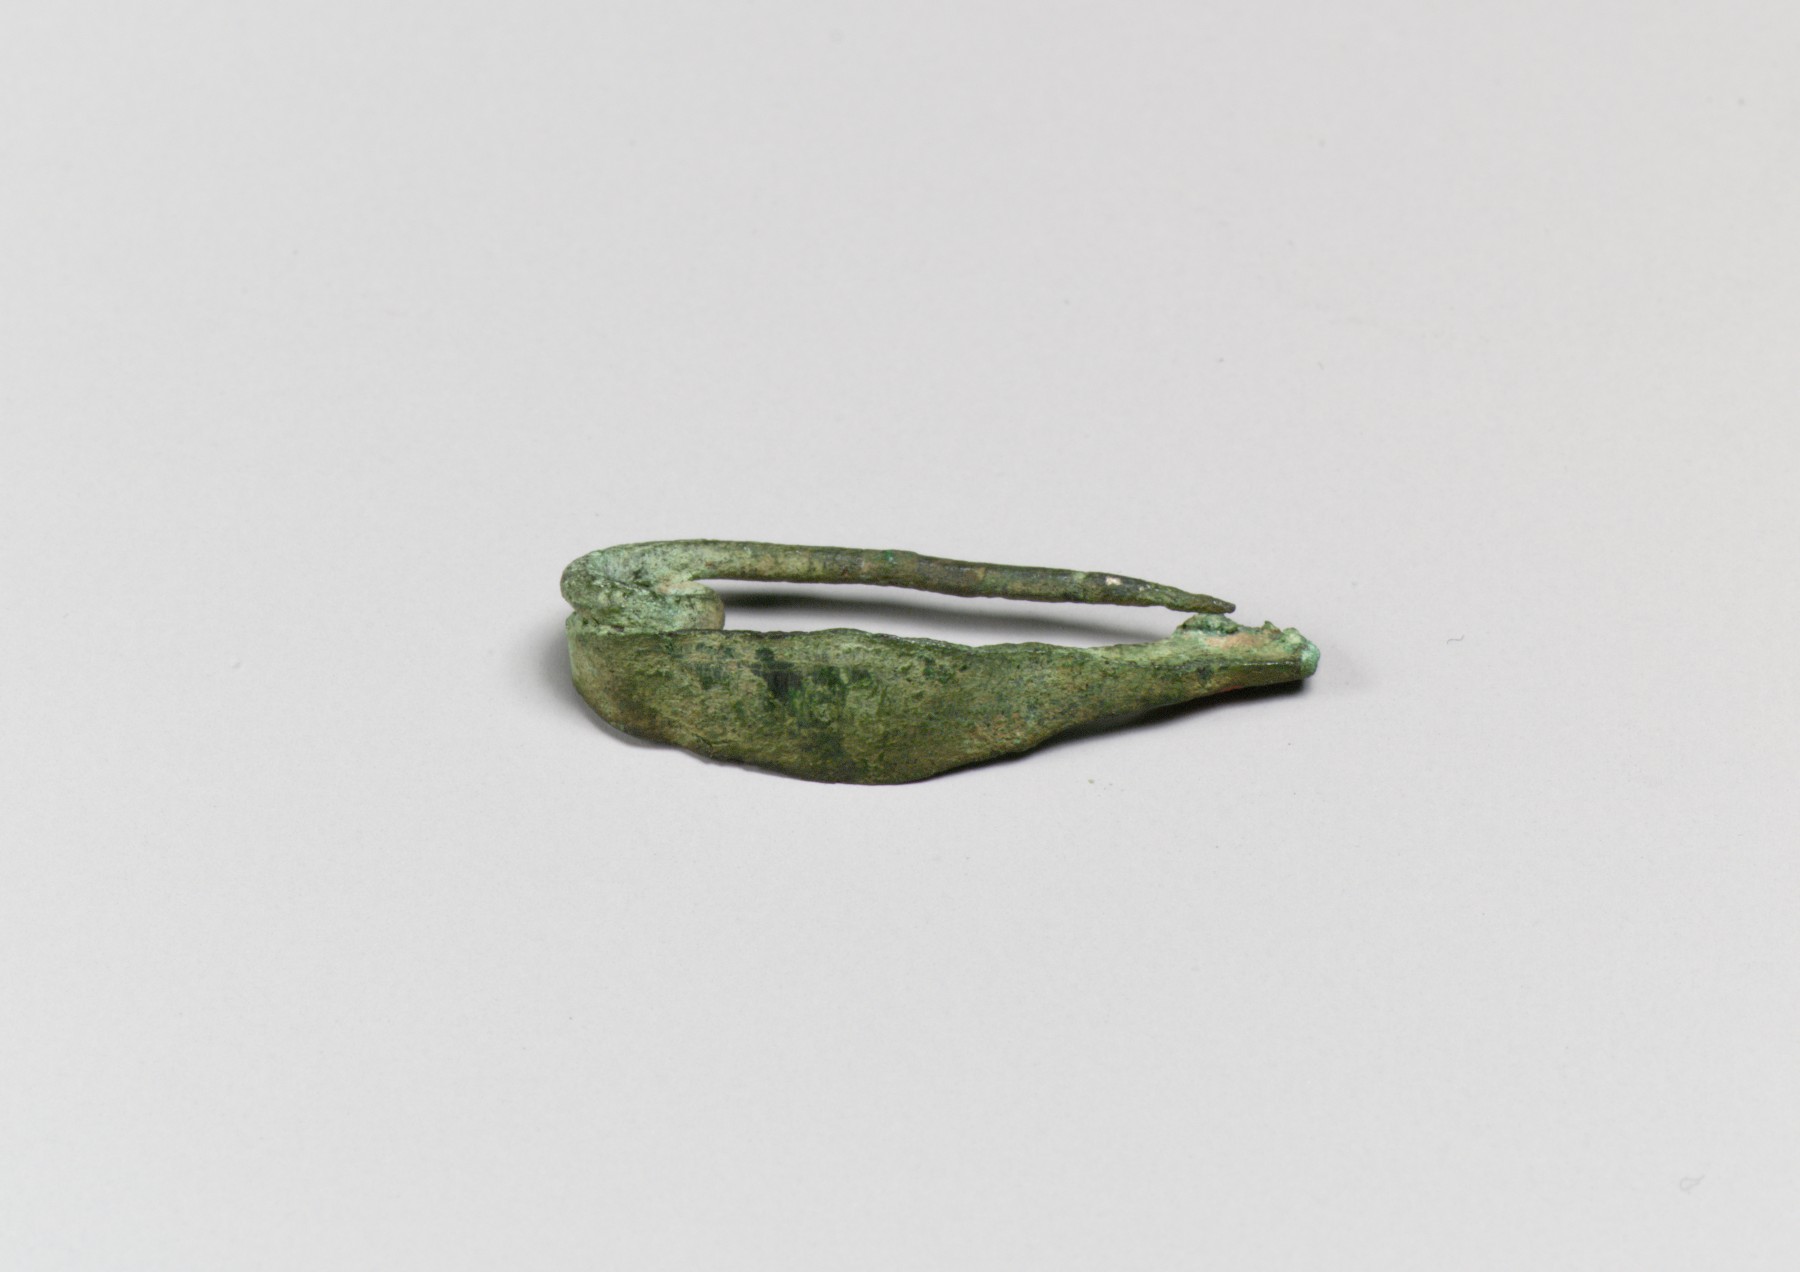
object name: fibula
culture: italic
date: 900-501 BCE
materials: bronze